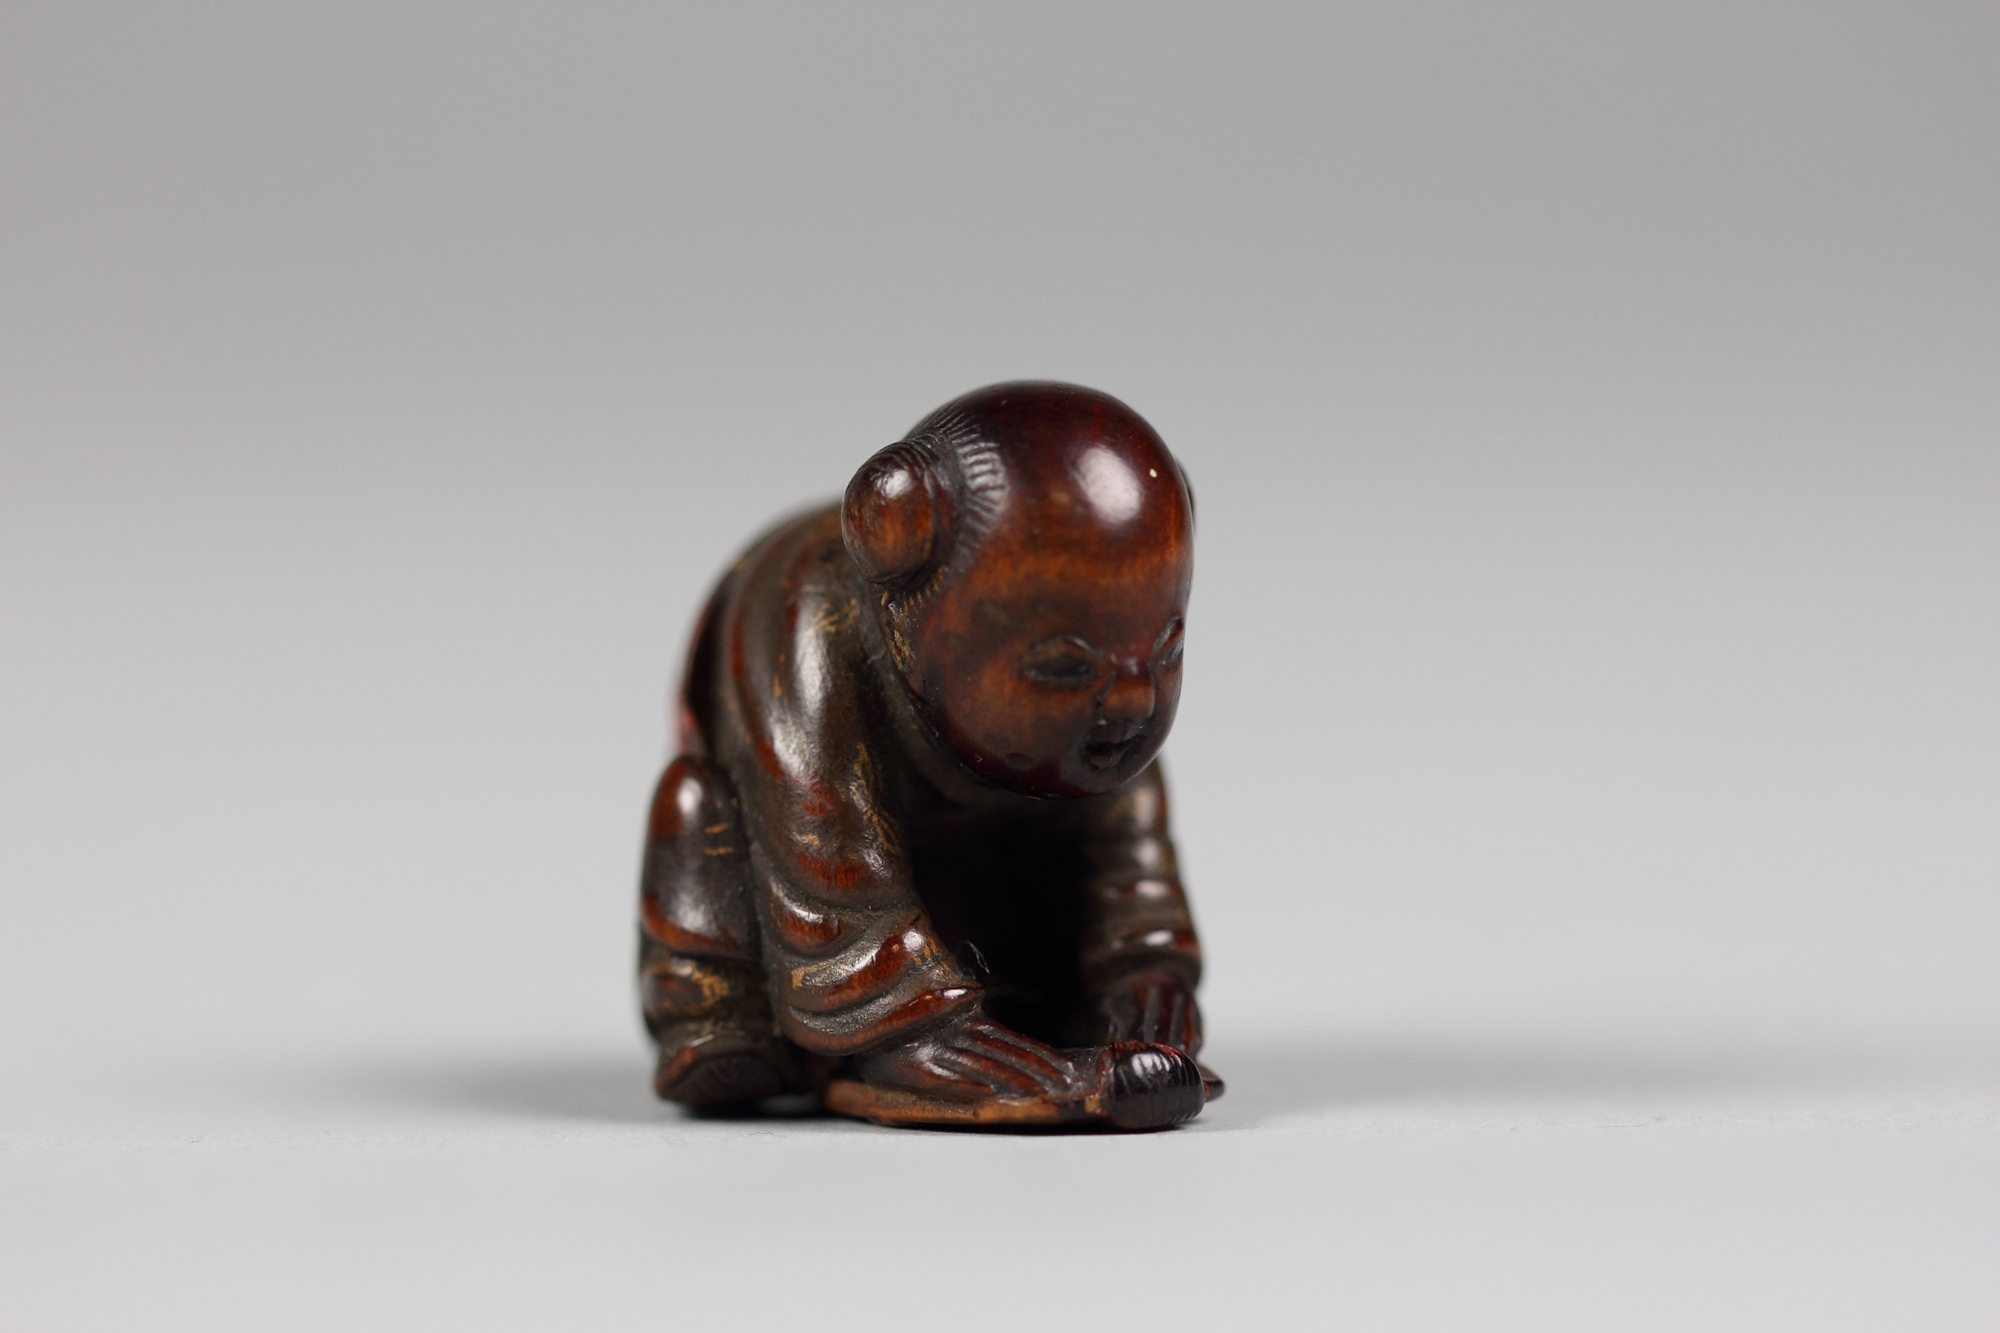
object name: netsuke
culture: japanese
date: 1801-1900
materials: gold, wood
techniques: lacquer